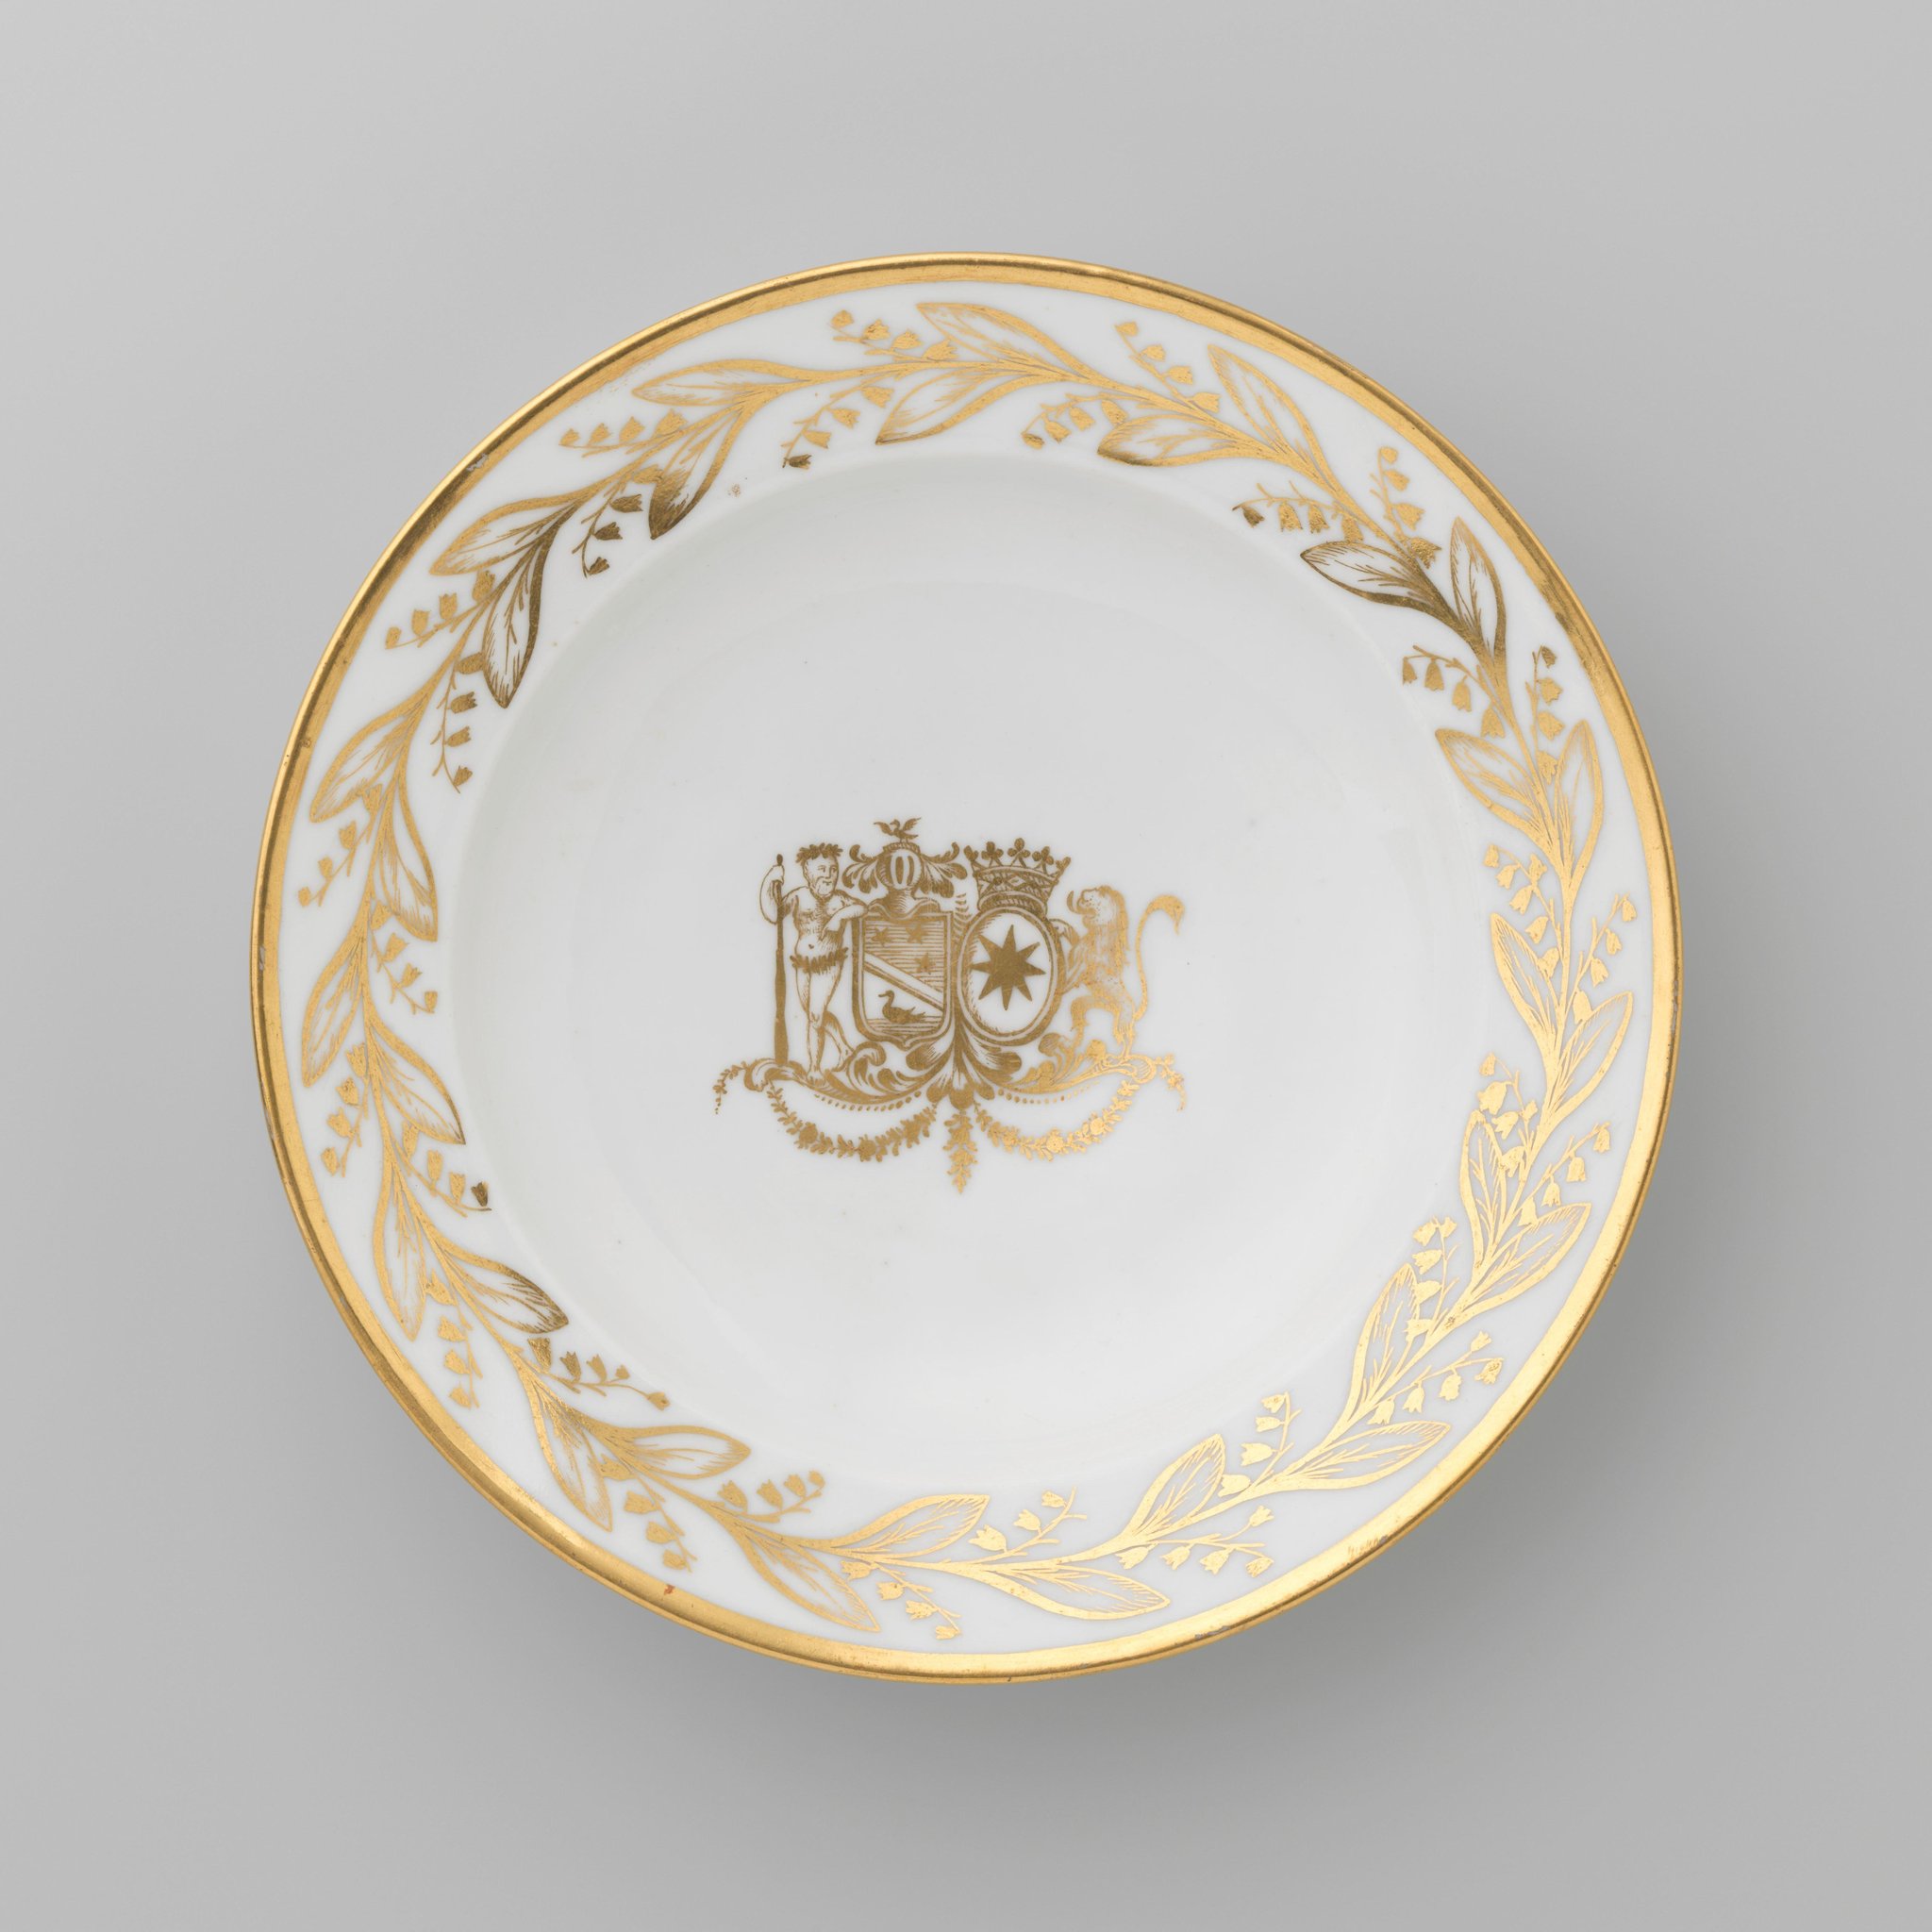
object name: plate dish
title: Plate with the coat of arms of Hendrik Peter Godfried Quack and Isabella Gertraud von Carnap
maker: Anonymous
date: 1790-1800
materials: glaze, gold, paint, porcelain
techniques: firing, forming, gilding, turning, vitrification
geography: netherlands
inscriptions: mark: ‘N’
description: Diep bord van porselein, beschilderd op het glazuur met goud. Op het plat het alliantiewapen van Hendrik Peter Godfried Quack en Isabella Gertraud von Carnap. De rand met een bloemrank en een gouden band. Een proen op de onderzijde. Gemerkt op de onderzijde met N.